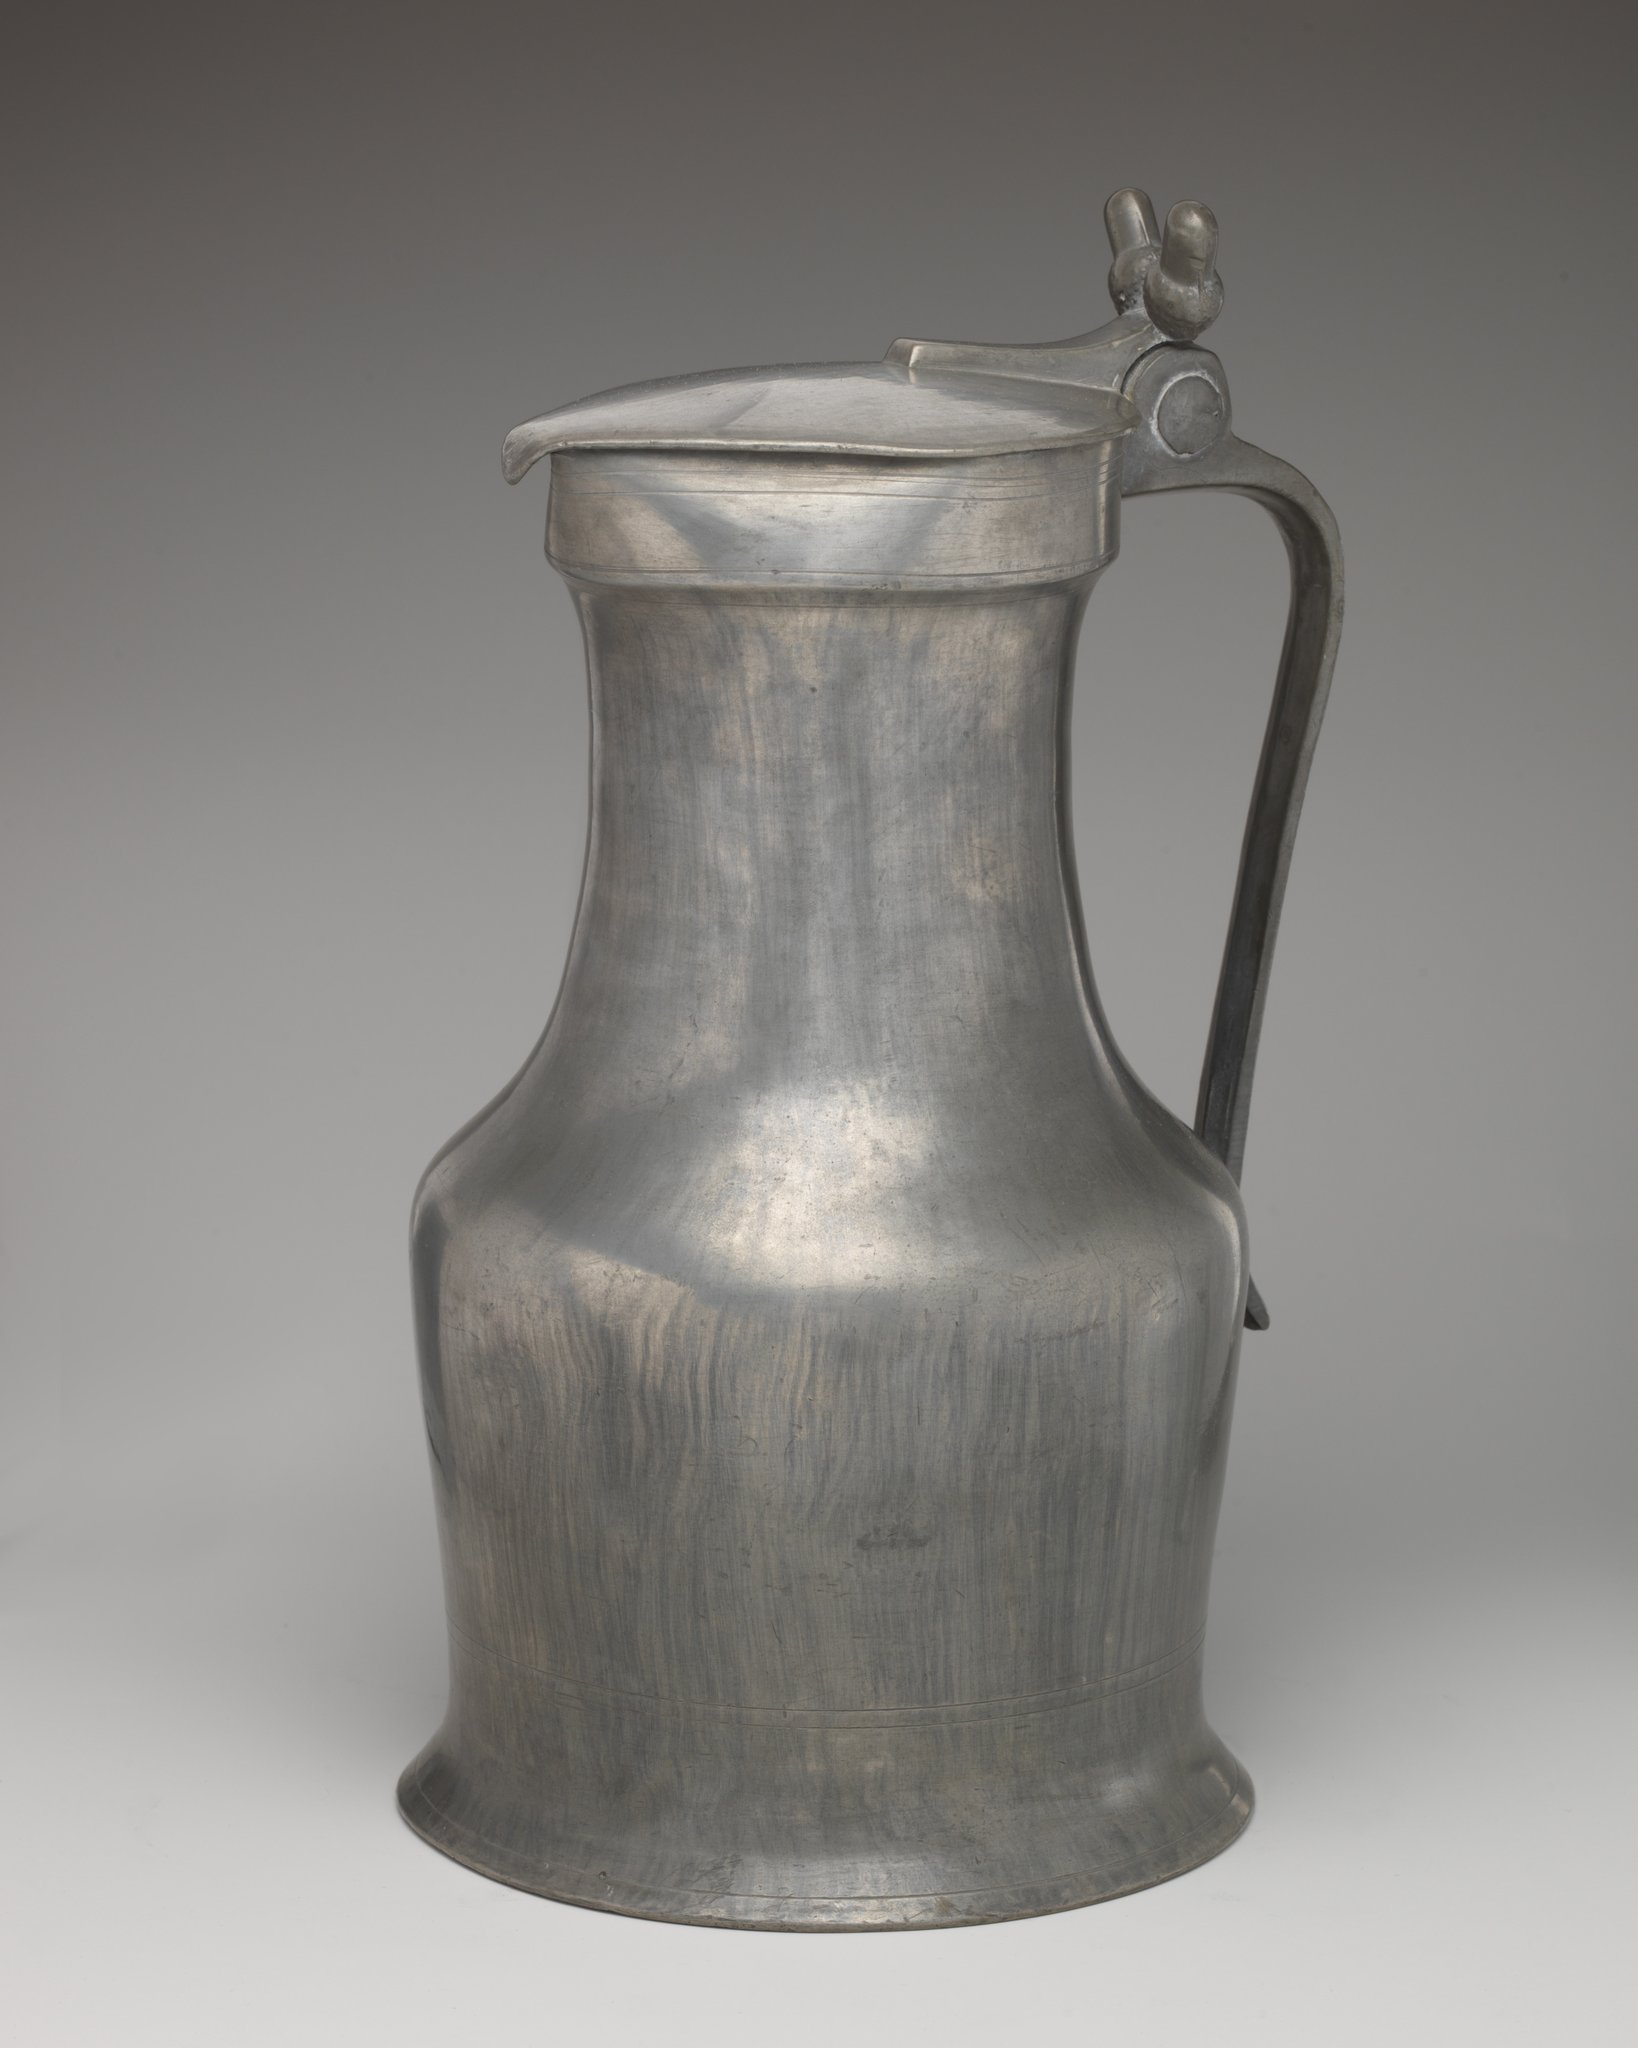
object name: measure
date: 1701-1733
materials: pewter